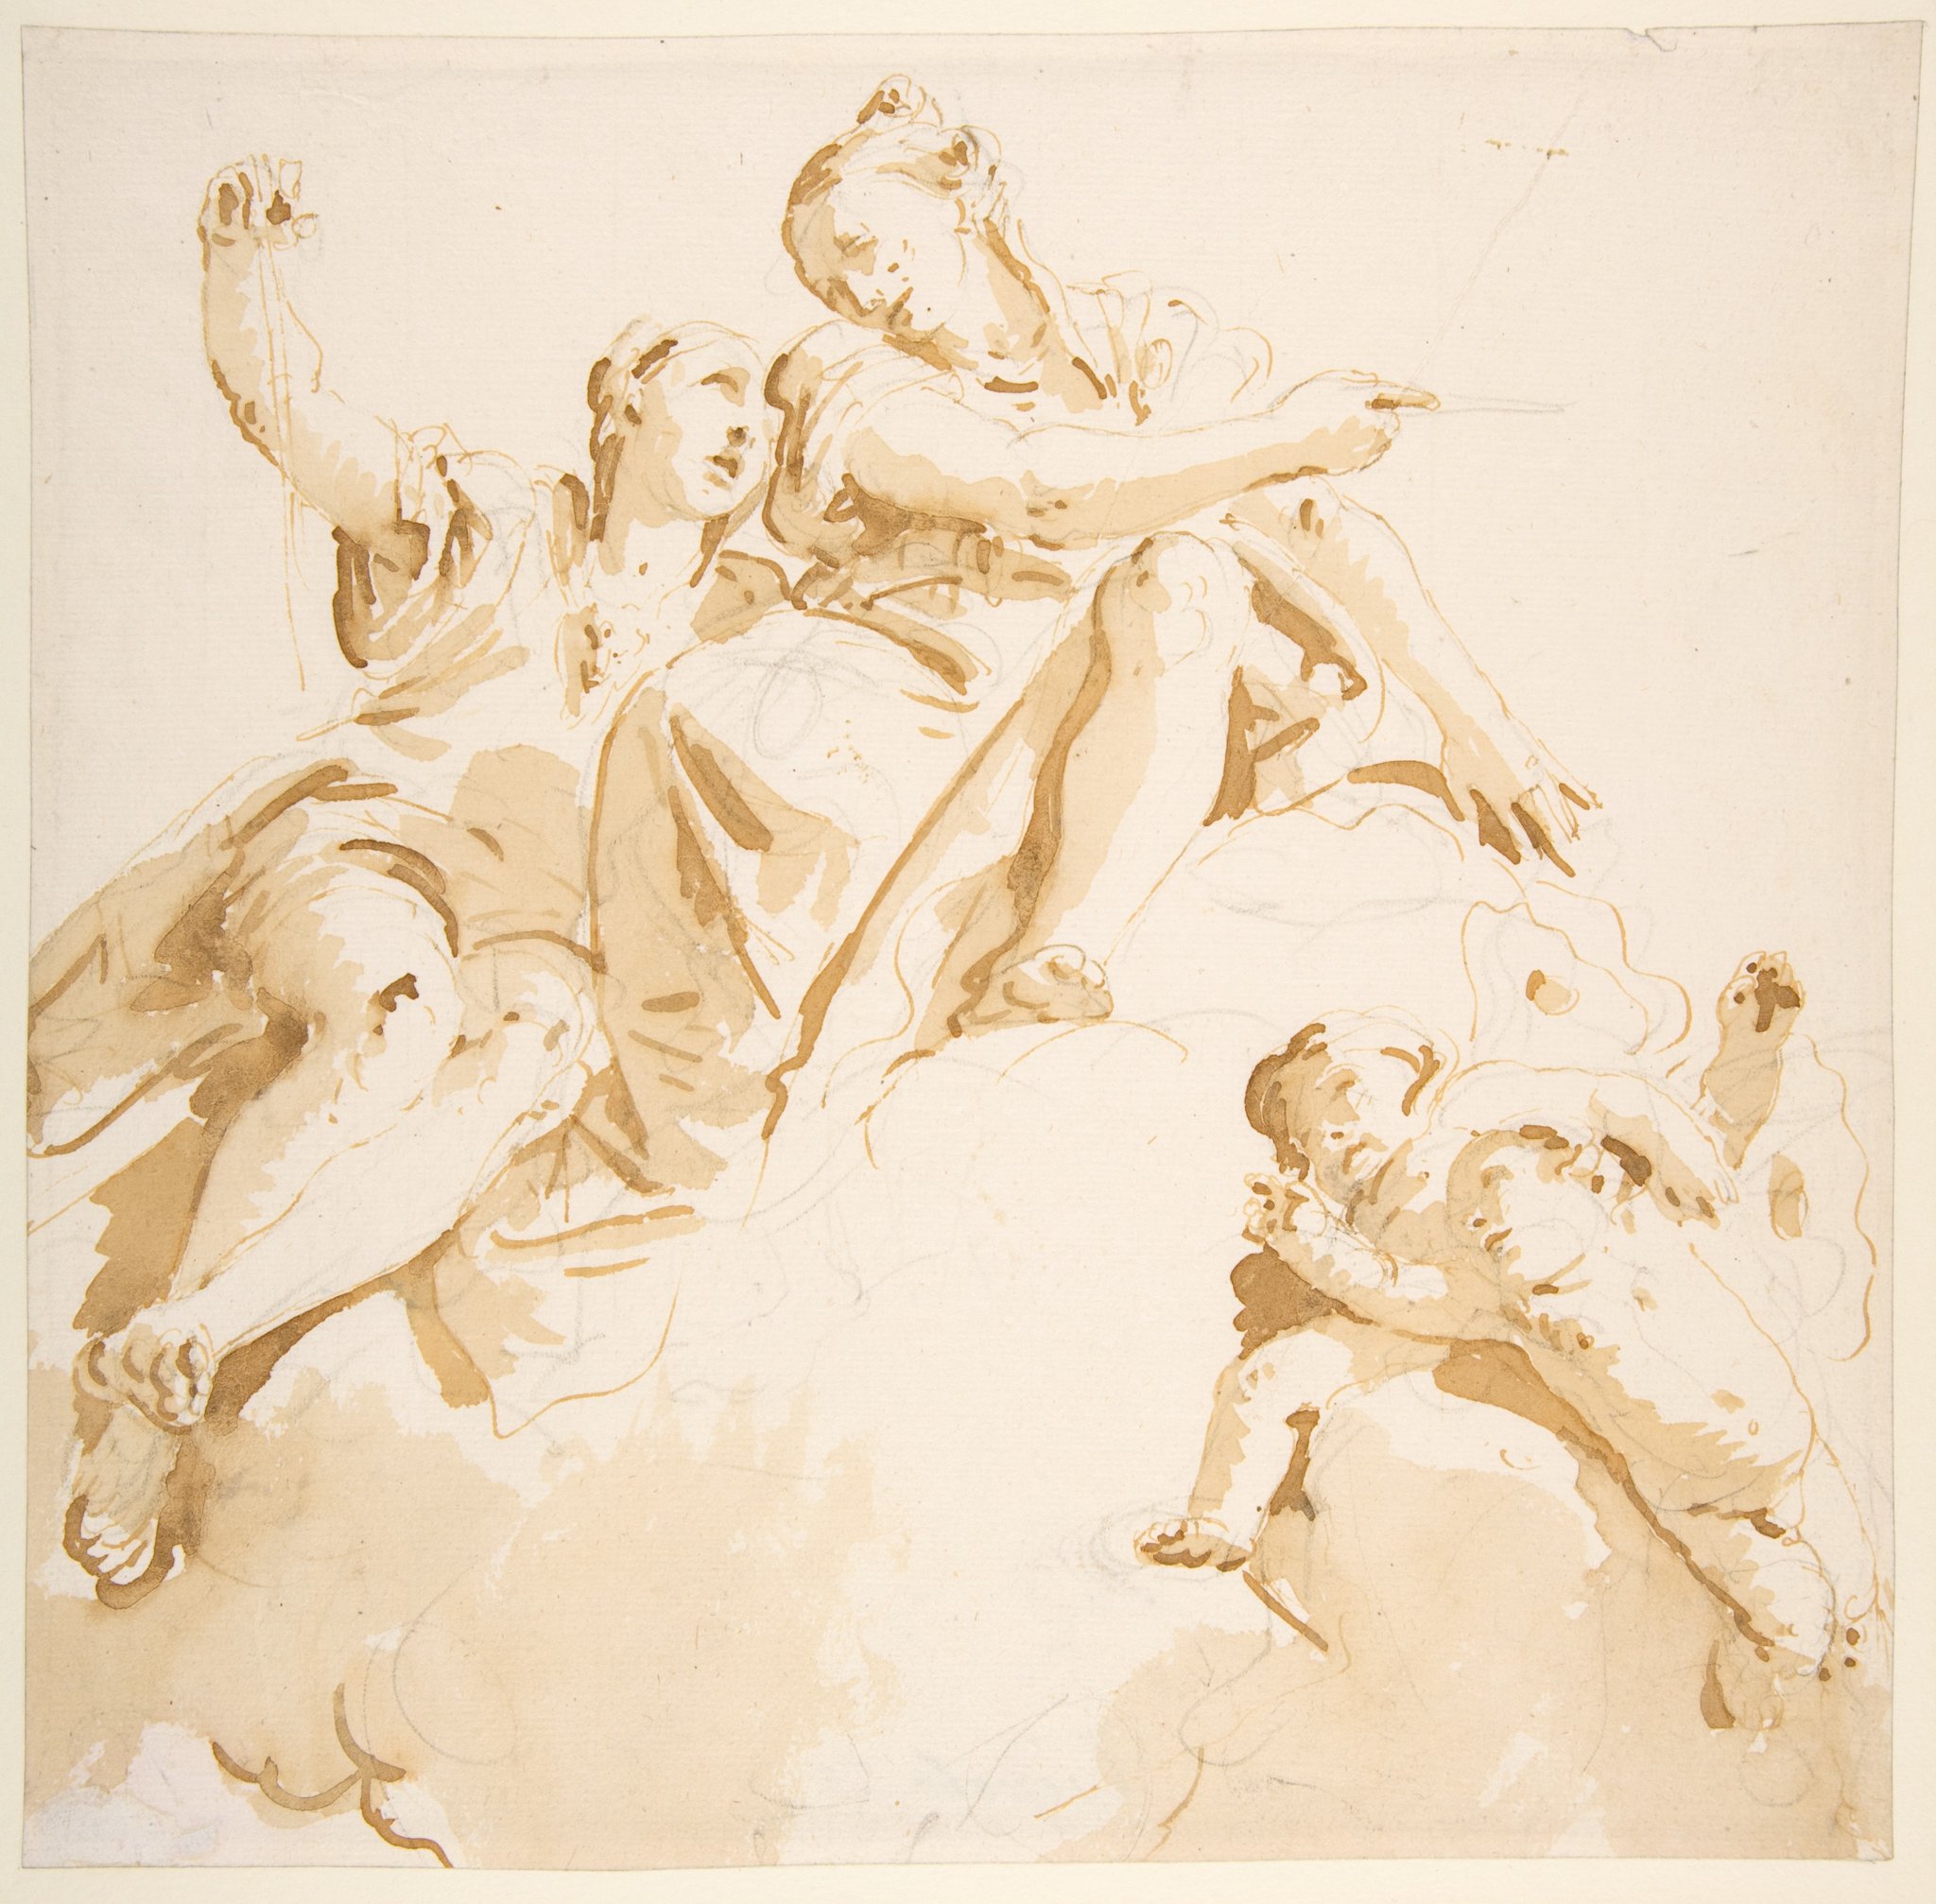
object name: drawing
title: Two Women Seated on a Cloud, and Two Putti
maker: giovanni battista tiepolo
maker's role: artist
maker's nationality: italian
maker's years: 1696-1770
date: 1696-1770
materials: chalk, ink, drawing material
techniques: brush, pen, wash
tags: women,putti